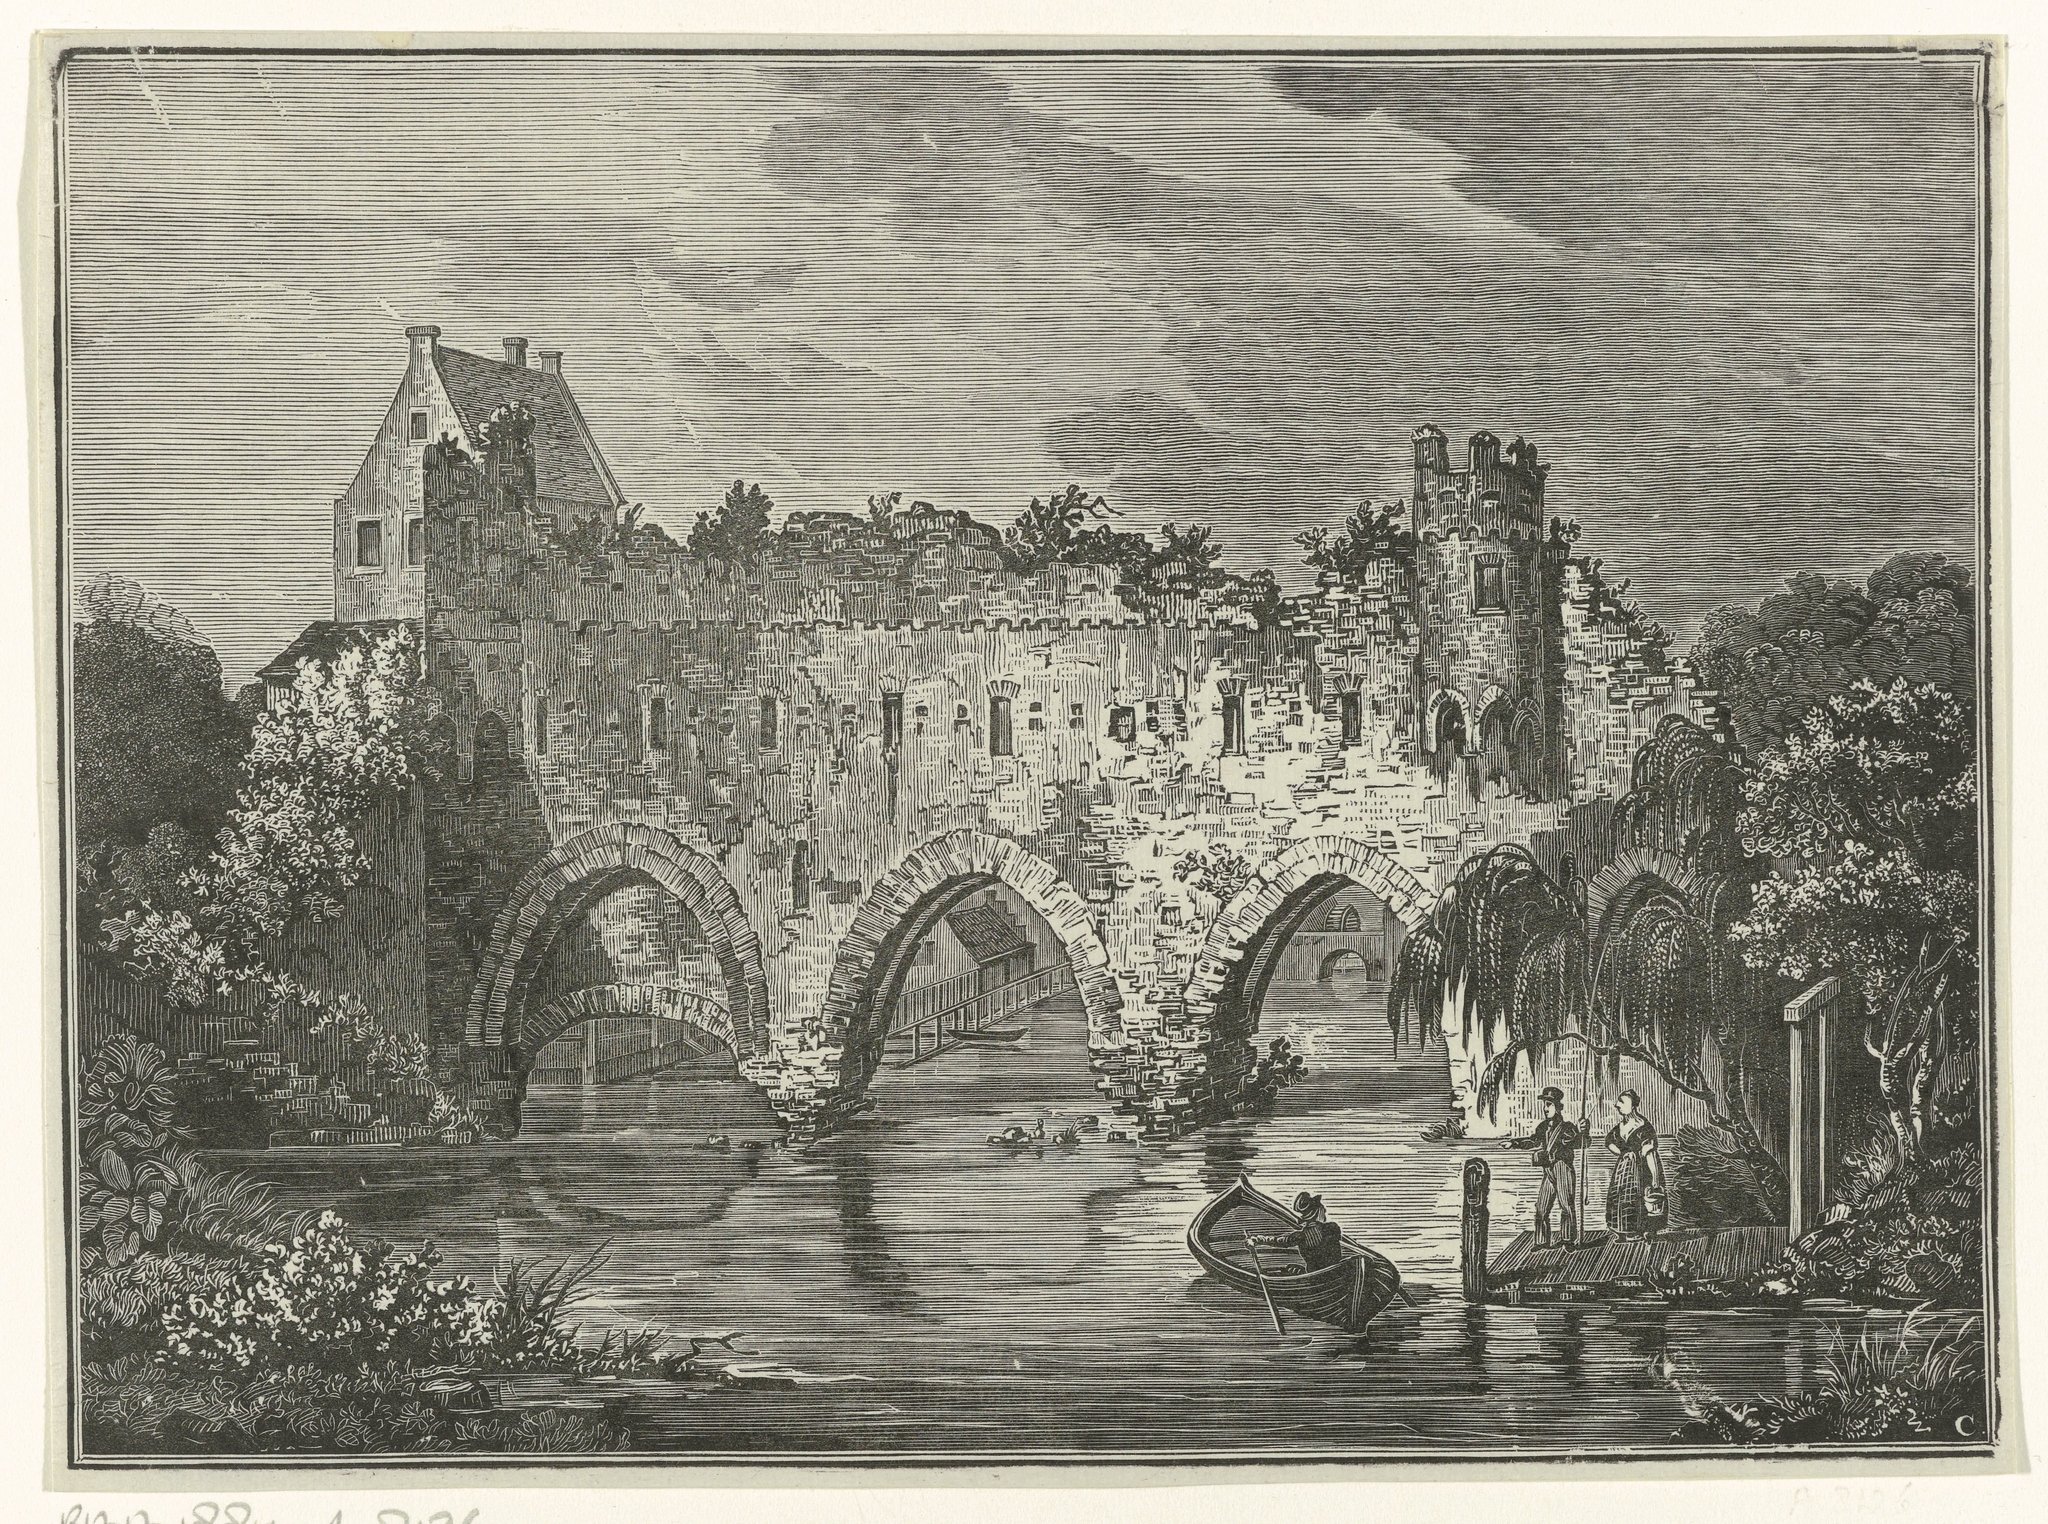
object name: print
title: Bouwval van de walmuur over de rivier de Berdeel te Zutphen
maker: alexander cranendoncq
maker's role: draughtsman, print maker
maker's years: 1799-1869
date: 1809-1869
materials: paper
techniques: engraving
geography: netherlands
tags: rowing-boat, canoe, etc., city-walls, river (+ landscape with figures, staffage)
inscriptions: collector's mark: Lugt 2228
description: Op de voorgrond staan een man en een vrouw op een steiger langs de rivier. Zij wijzen naar een man in een roeiboot.